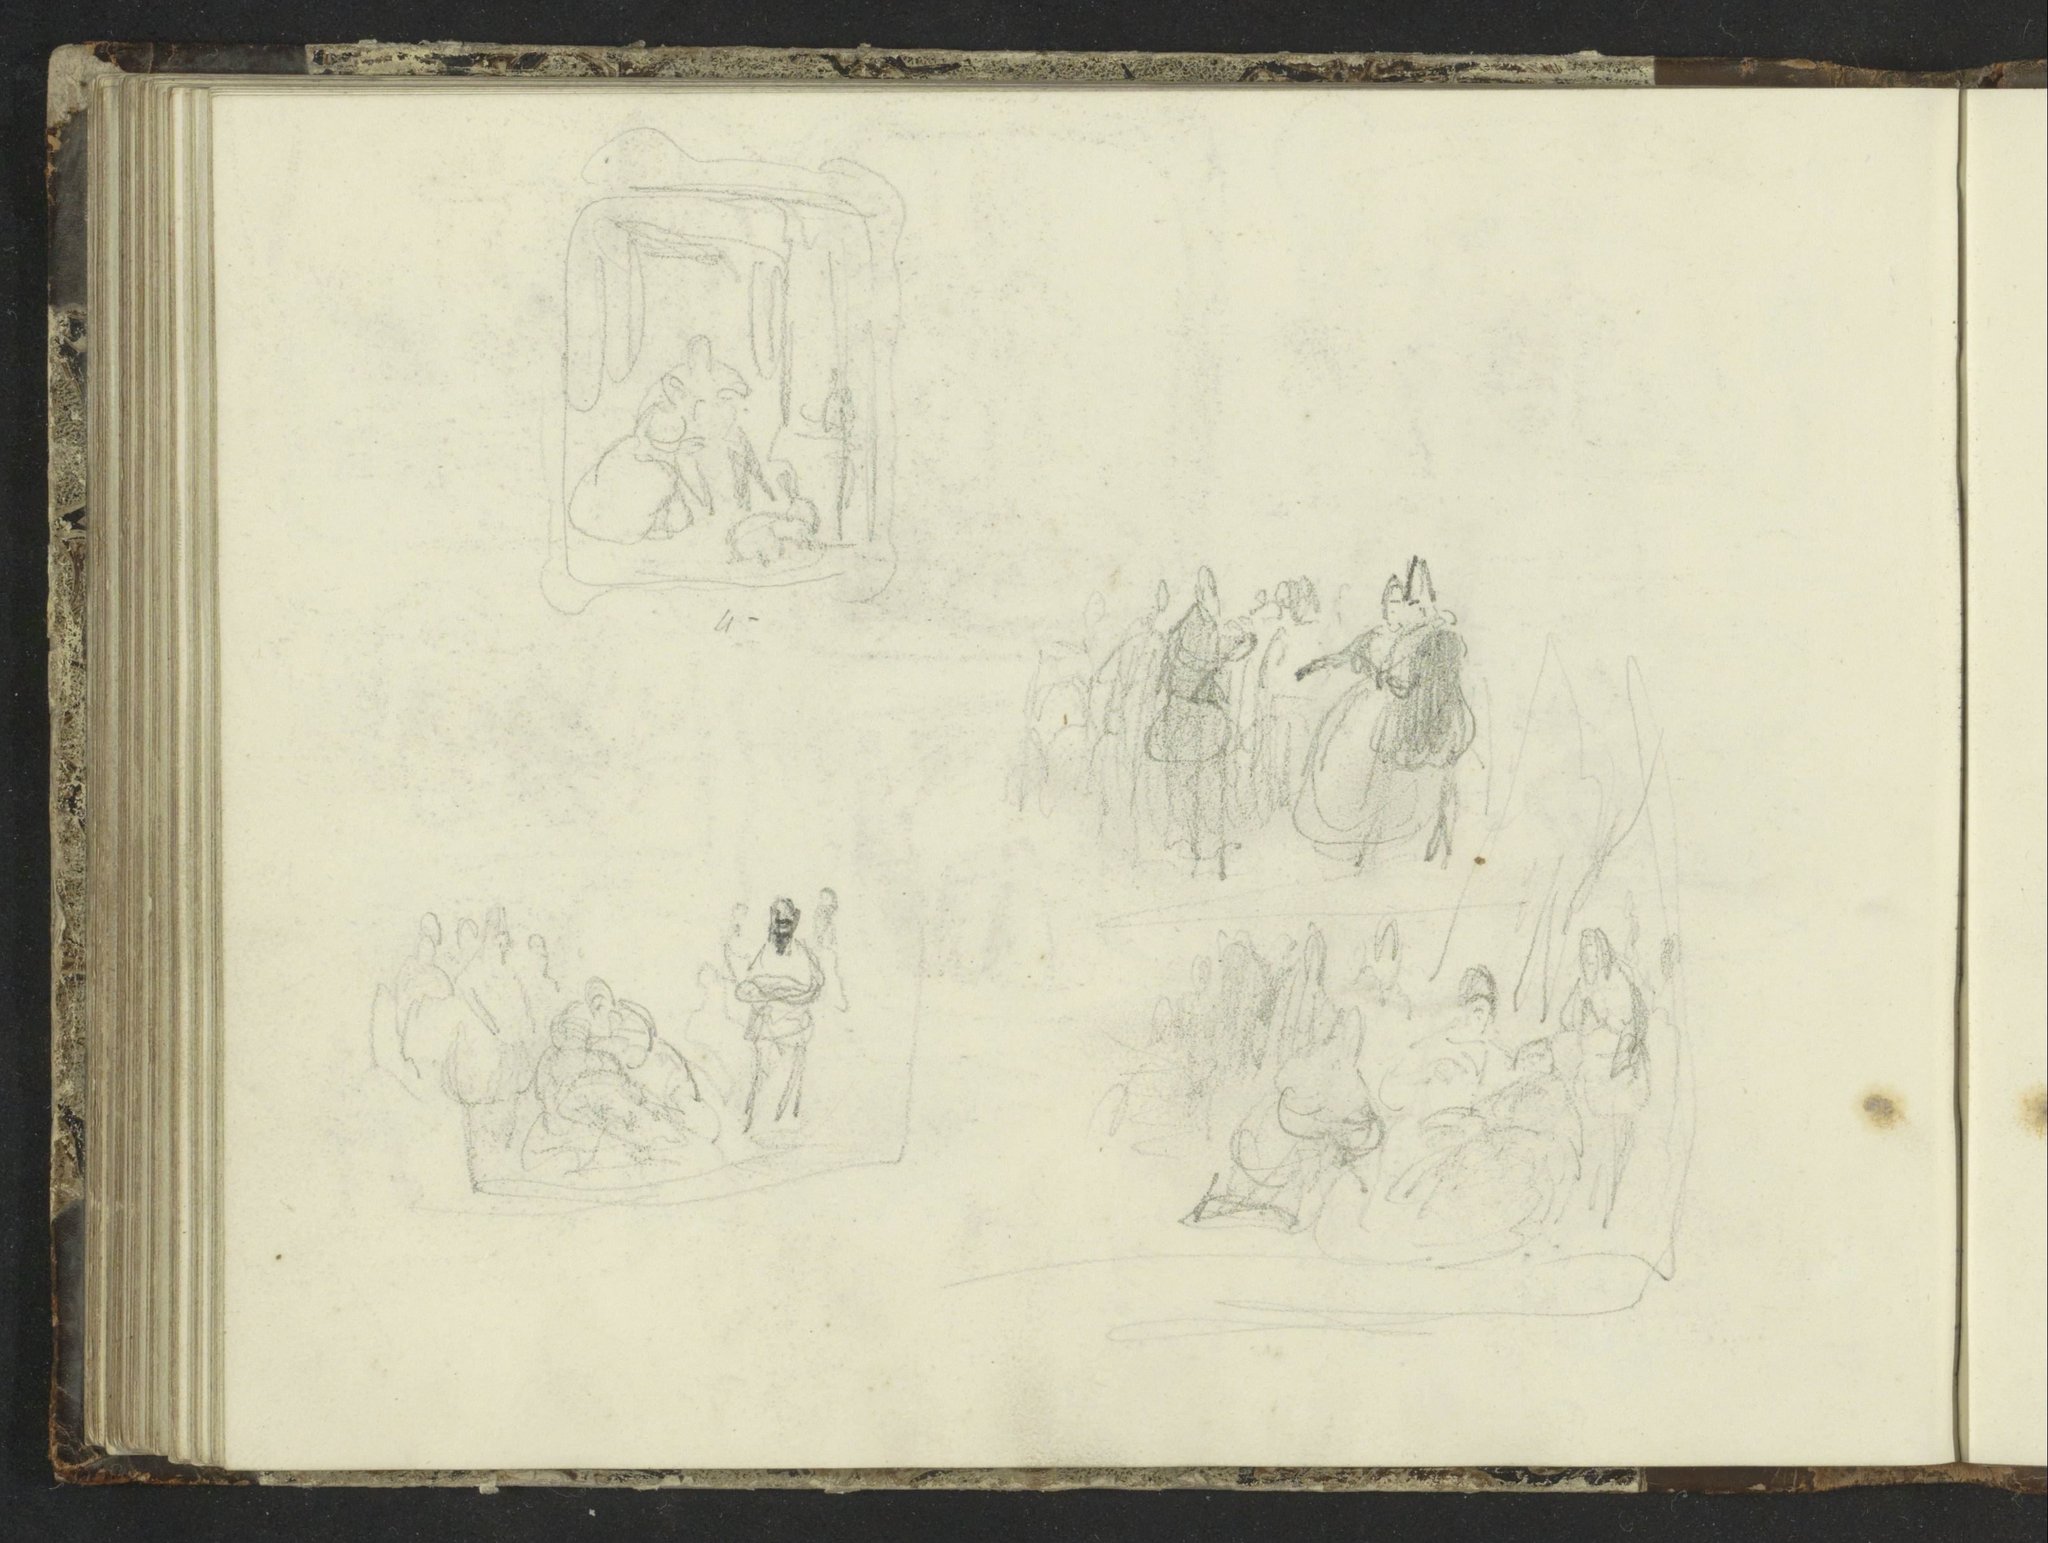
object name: sketchbook leaf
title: Compositiestudies met groepen figuren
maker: willem hendrik schmidt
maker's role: draughtsman, painter, print maker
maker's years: 1809-1849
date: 1819-1849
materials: paper, pencil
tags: anatomy (non-medical)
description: Tekeningen in kaders. Vermoedelijk kopieën naar schilderijen. Blad 49 verso uit een schetsboek met 58 bladen.